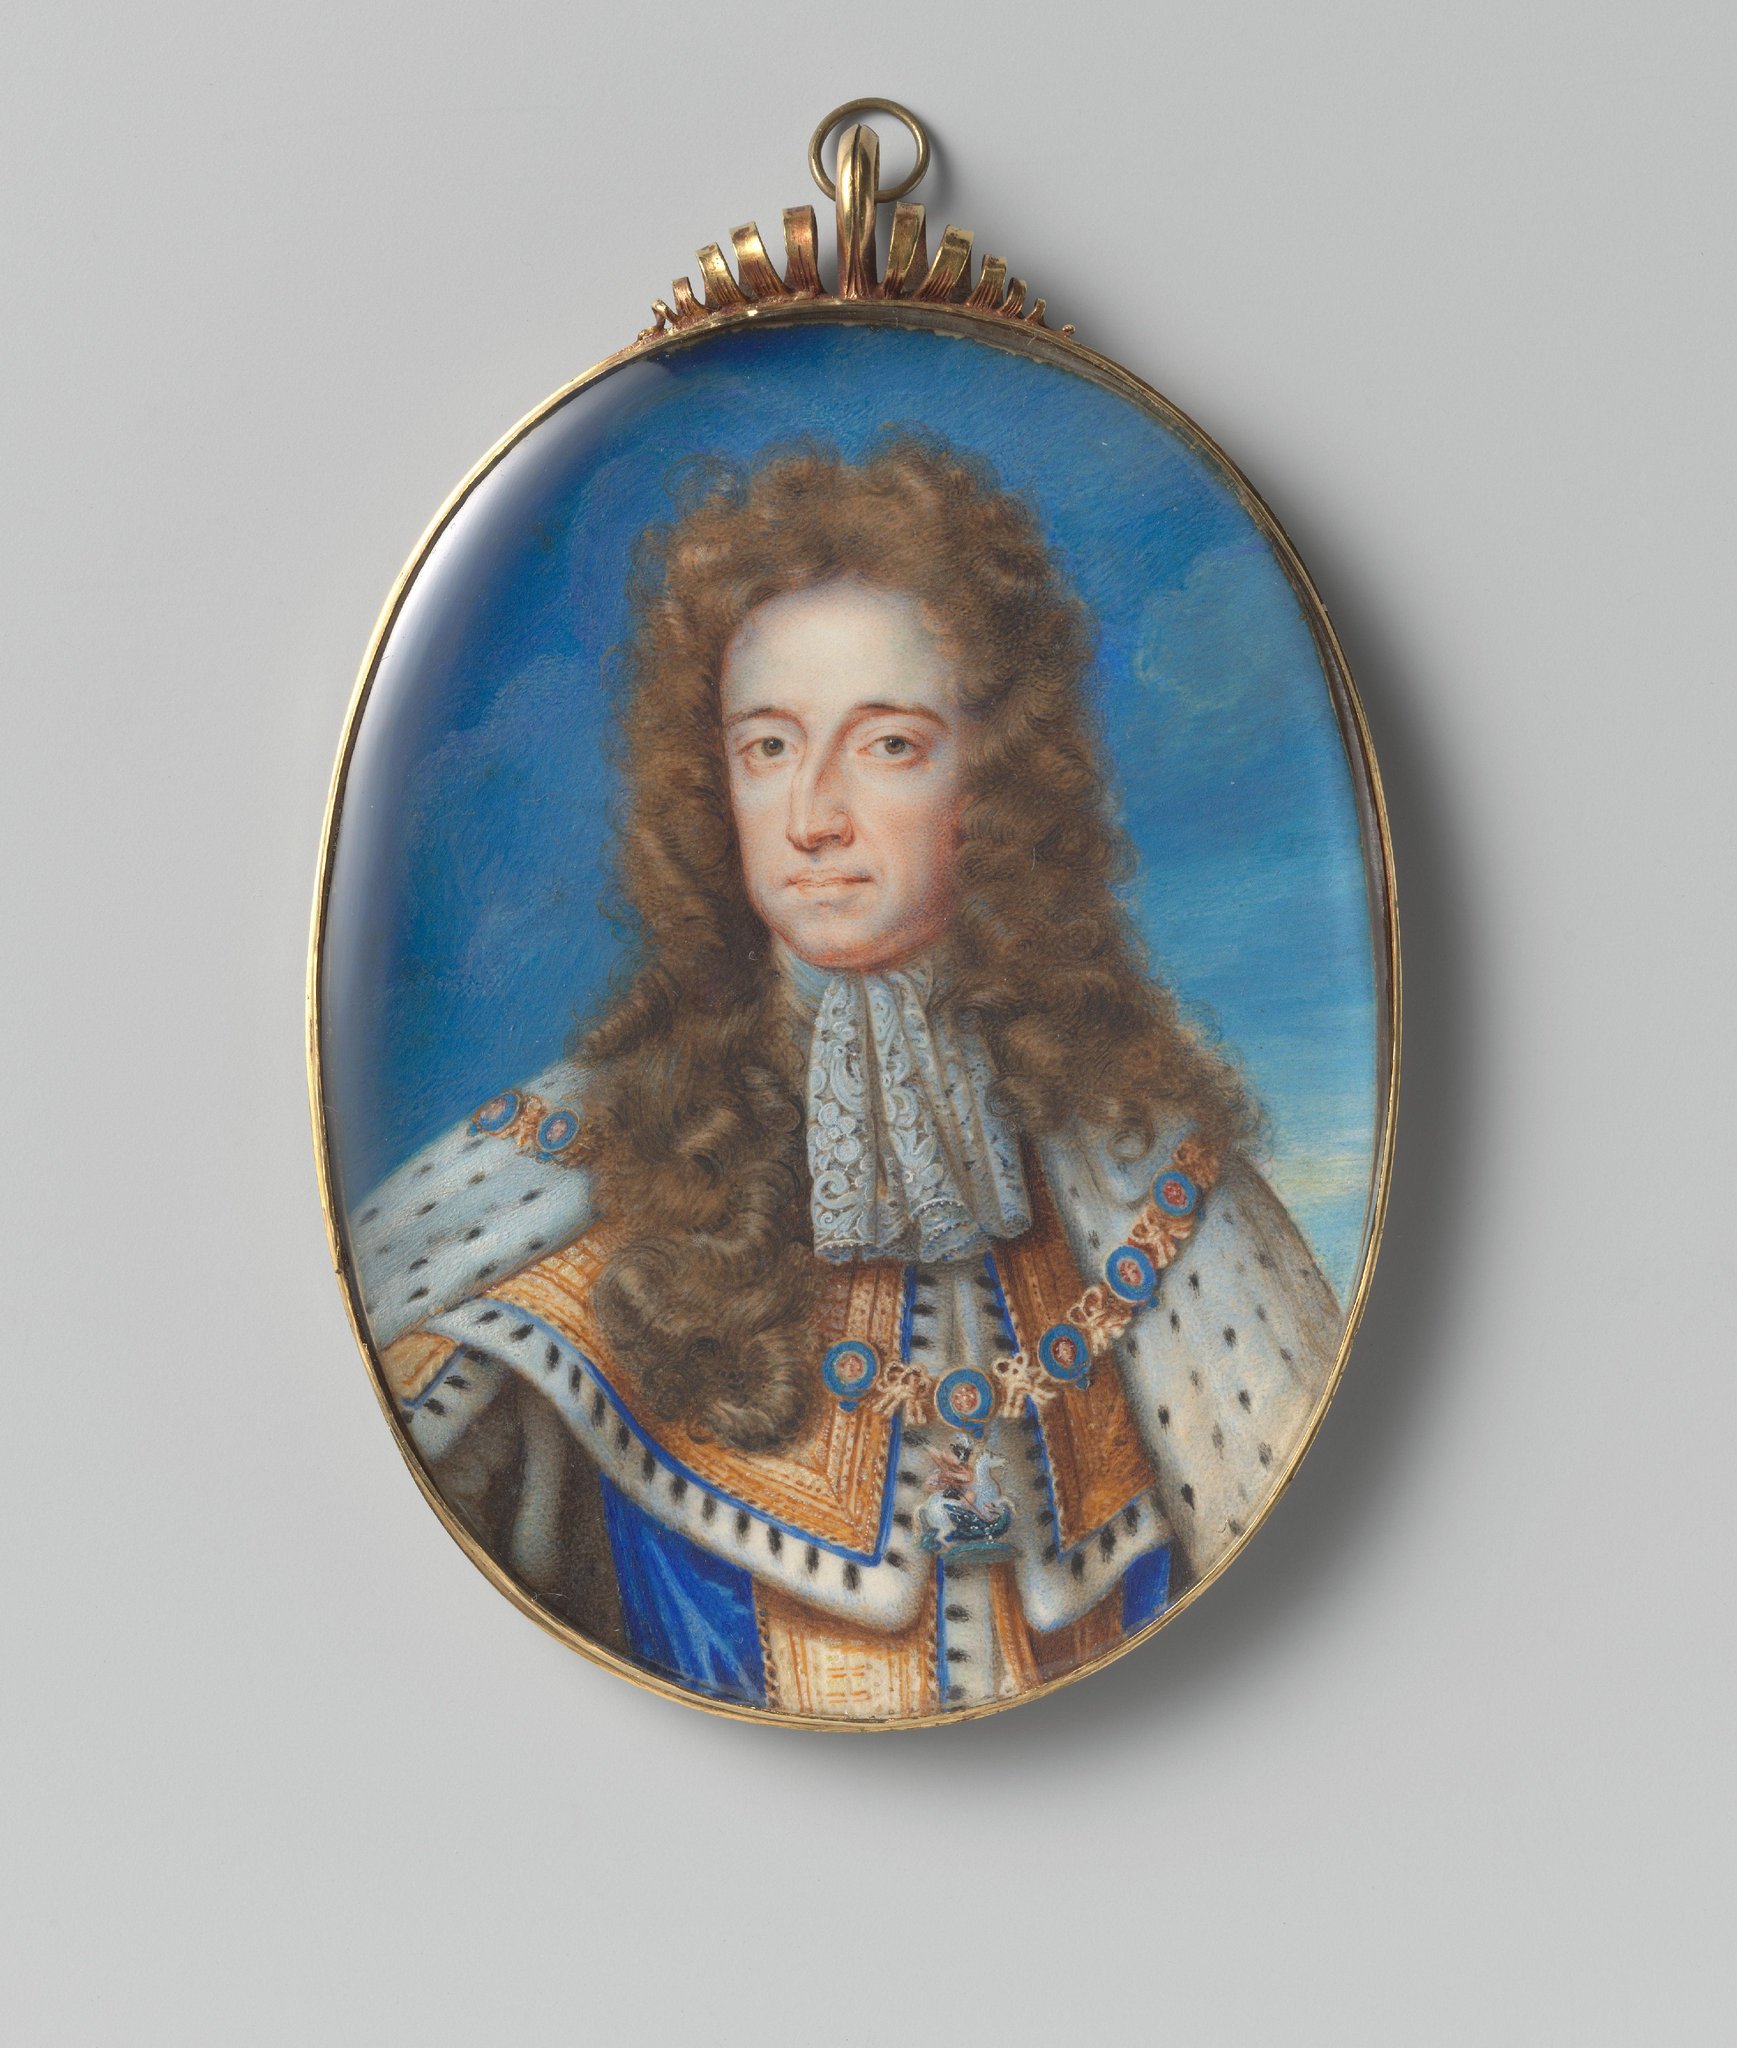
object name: painting, miniature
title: Portrait of William III (1650-1702), prince of Orange. From 1689 on king of England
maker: benjamin arlaud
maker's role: miniatuurschilder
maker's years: 1670-1731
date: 1689-1719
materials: cardboard, glass, gold, oil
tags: the hague, william iii (prince of orange and king of england, scotland, and ireland)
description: Portret van Willem III (1650-1702), prins van Oranje. Sedert 1689 koning van Engeland. Buste, aanziend, in koninklijk ornaat. Om zijn hals draag hij de keten van de Orde van de Kouseband. Onderdeel van de collectie portretminiaturen.